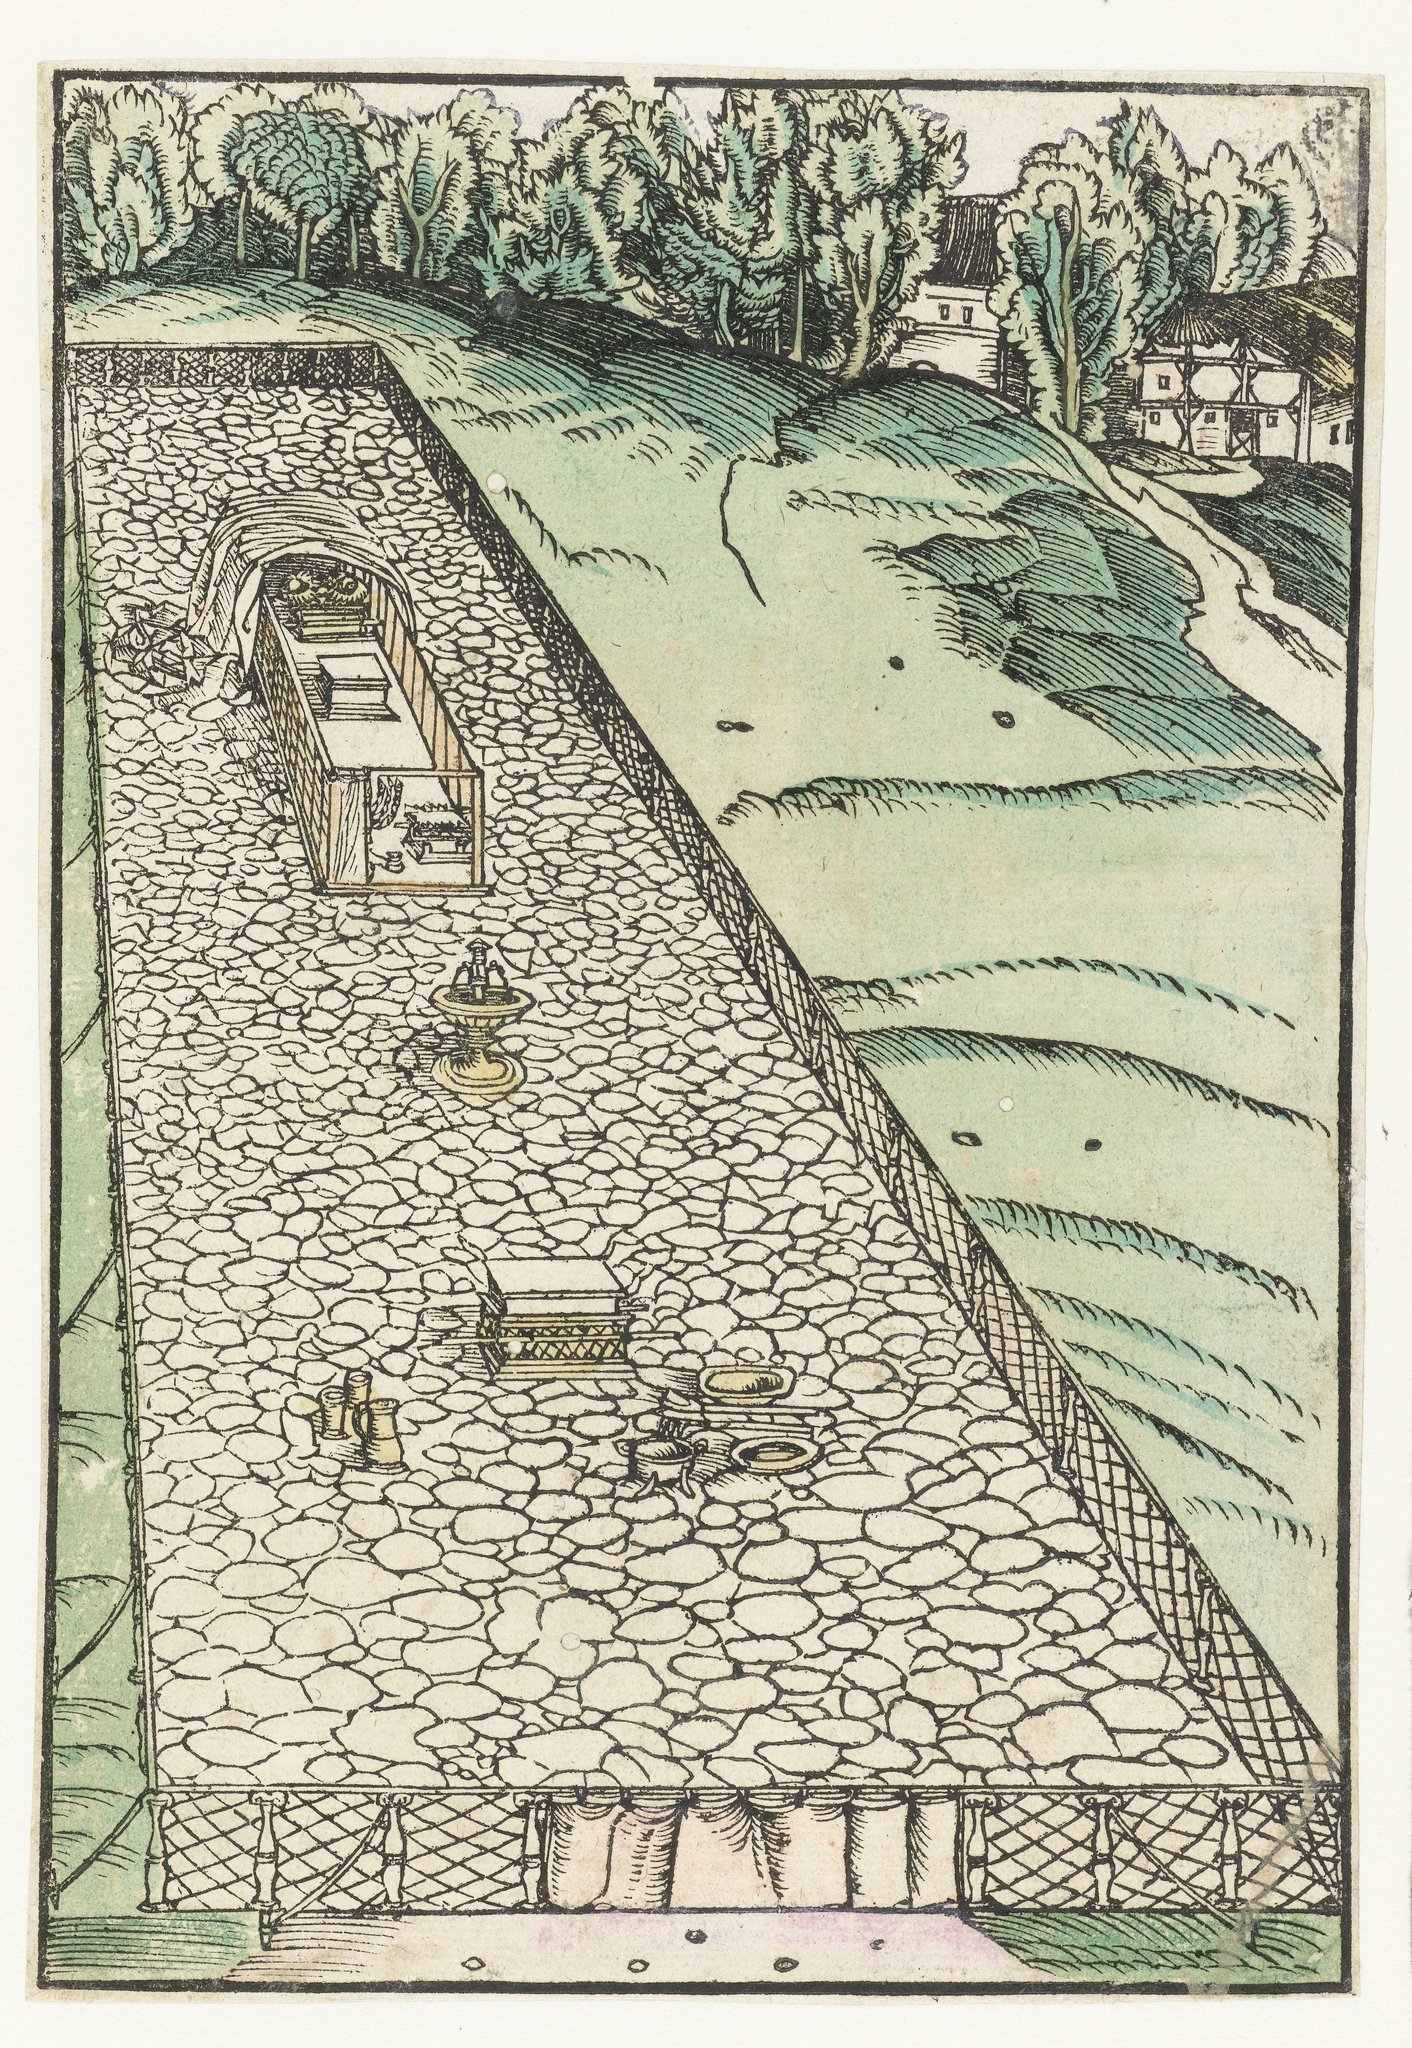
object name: book illustration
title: Hof met het tabernakel, brandofferaltaar en wasvat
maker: lucas cranach (i)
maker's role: draughtsman, print maker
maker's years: 1472-1553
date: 1523-1526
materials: paper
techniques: hand coloring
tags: tent of meeting, ''ohel mo'ed', tent of the testimony, 'mishkan ha-'edut' (tabernacle ~ jewish religion), the court of the tabernacle ~ jewish religion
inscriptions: collector's mark: Lugt 2233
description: Houtblokken gebruikt voor: Das Alte Testament deutsch, deel I, Wittenberg 1523 (eerste druk) maar ook later (tot 1526) verschenen drukken waarin de houtblokken werden gebruikt. De serie van elf boekillustraties in de collectie van het RMA heeft blanco verso zijden, dit is kenmerkend voor deze uitgaven van Luthers bijbel, zie Koepplin 1974, p. 341.